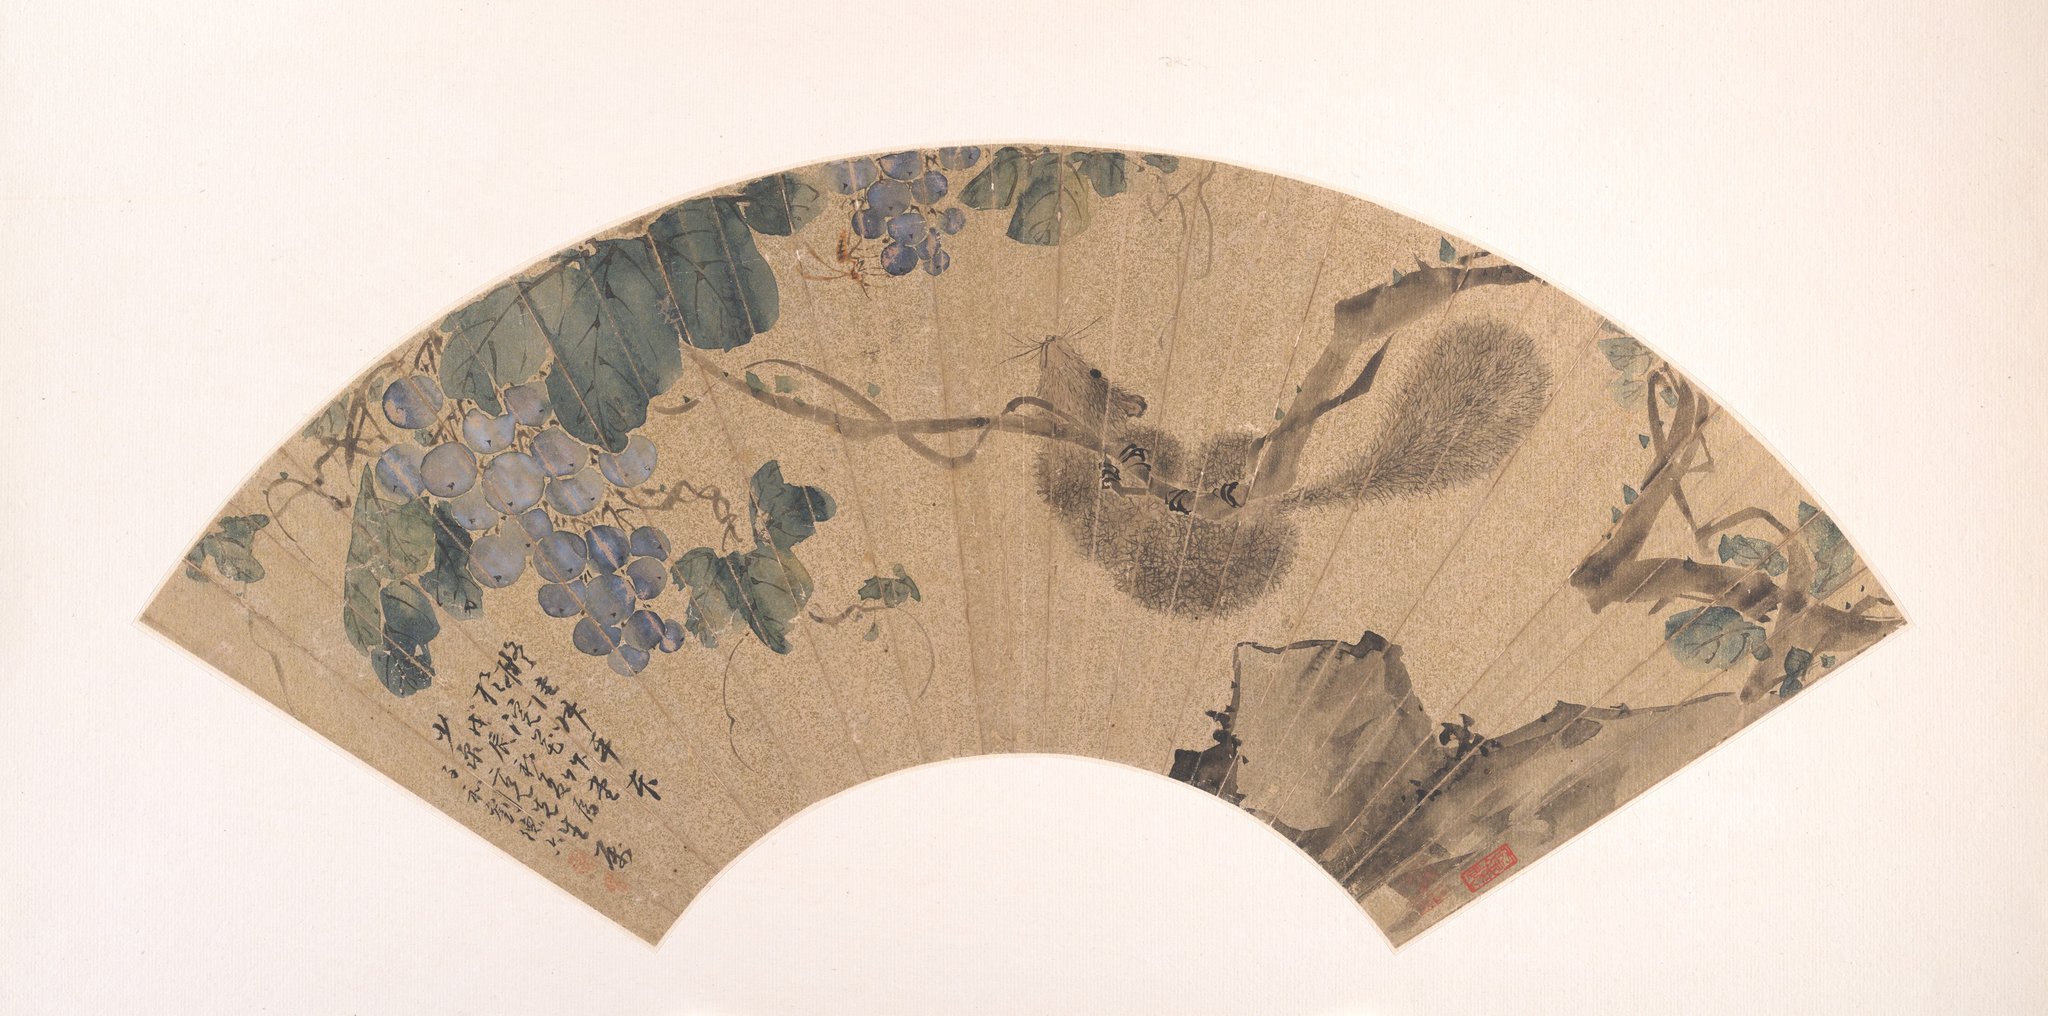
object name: folding fan mounted a an album leaf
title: Squirrel and Grape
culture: chinese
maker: liu deliu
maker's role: artist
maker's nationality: chinese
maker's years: 1806-1875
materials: ink, paper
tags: grapes,squirrels